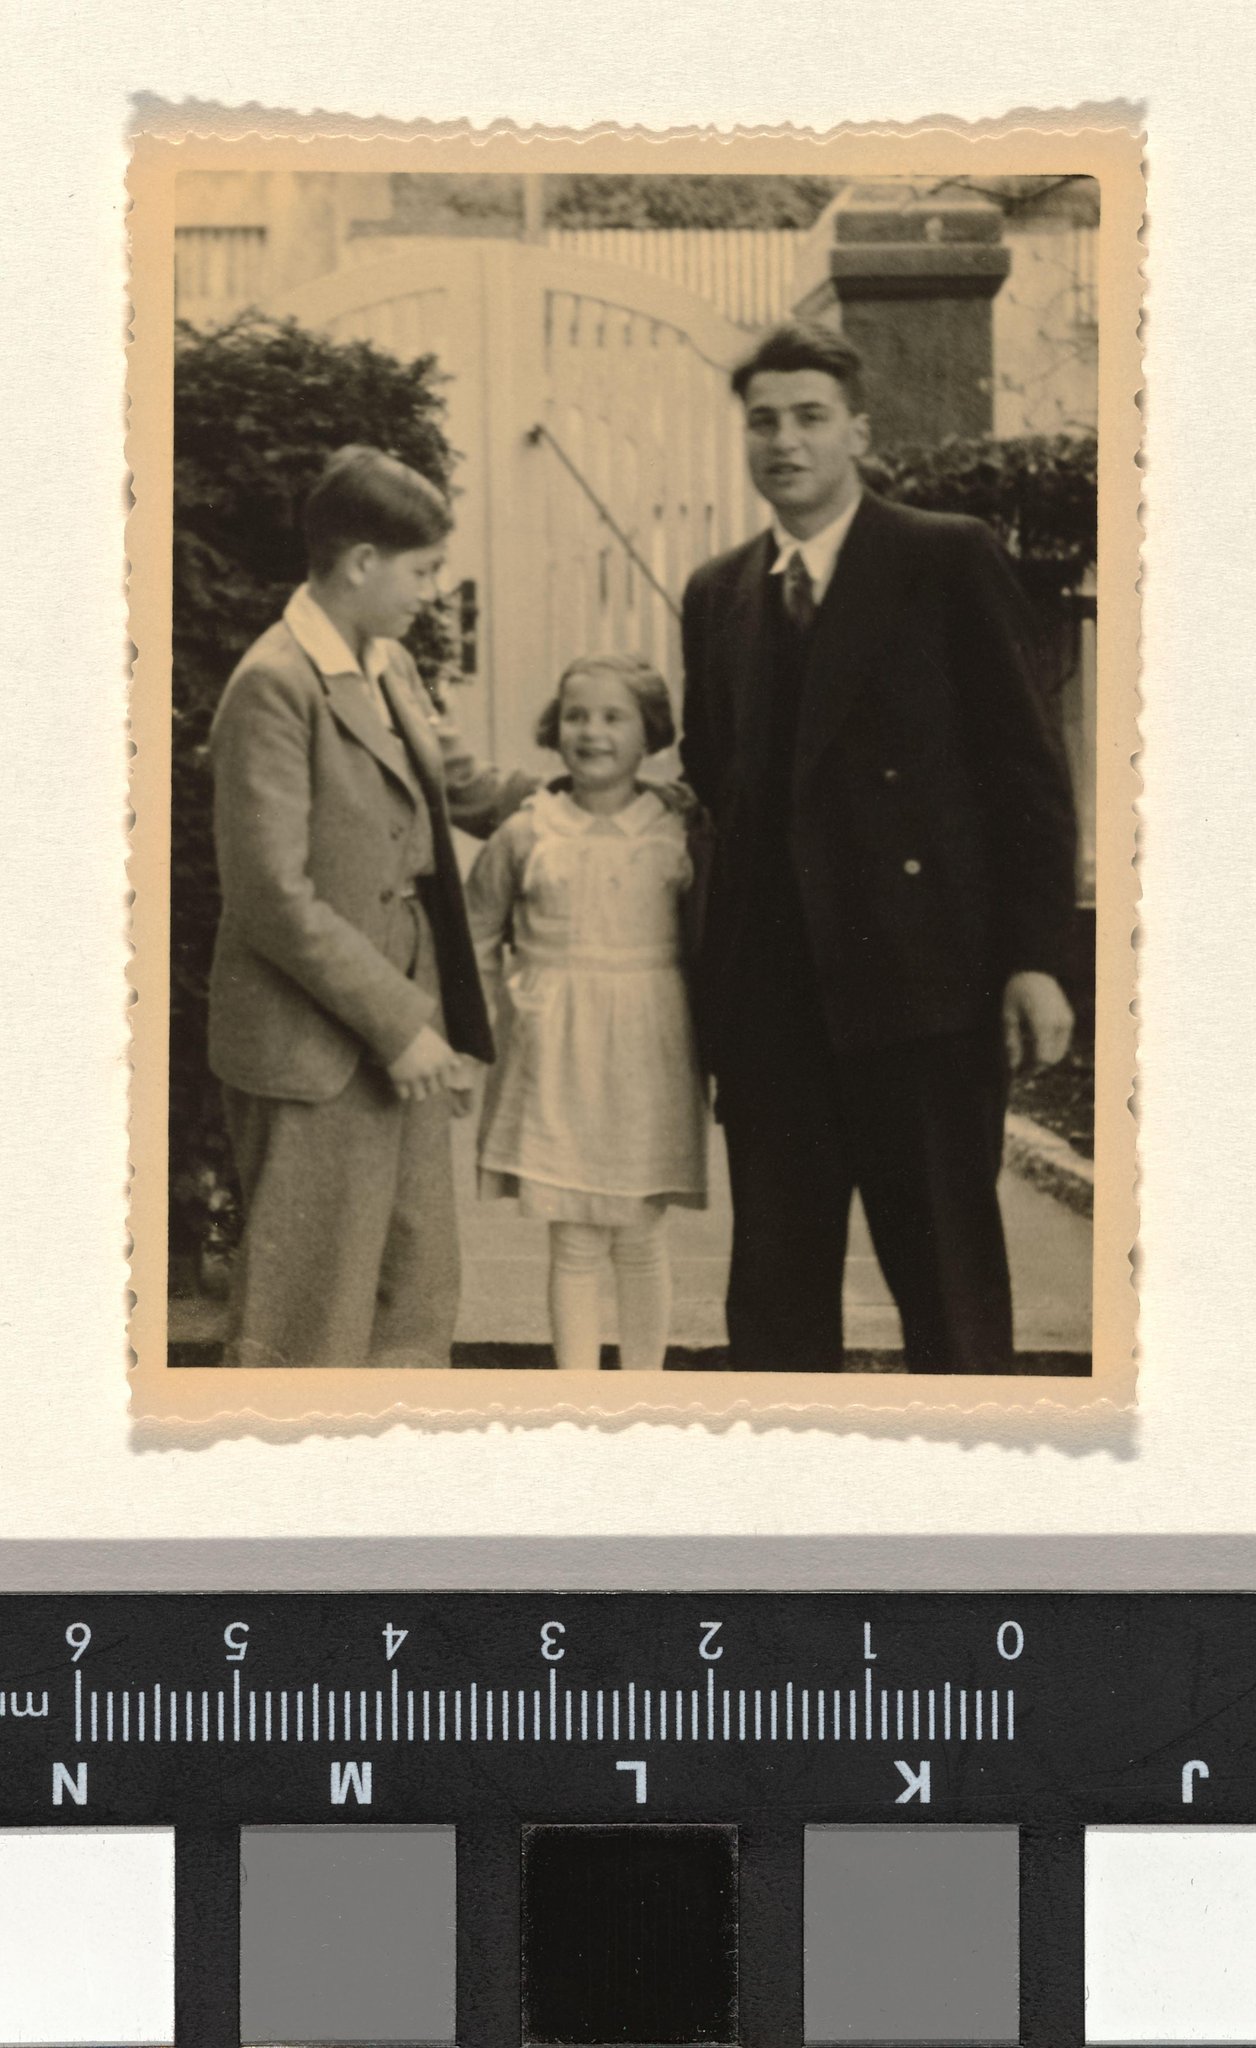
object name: photograph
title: Isabel Wachenheimer met haar neven Klaus en Werner Zürndorfer, in de tuin van de familie Wachenheimer in Stuttgart, 1935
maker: Anonymous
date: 1935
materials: photographic support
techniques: gelatin silver print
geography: stuttgart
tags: leiden, isabel wachenheimer-elon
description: Dit object is onderdeel van de nalatenschap van Isabel Elon-Wachenheimer (1928-2010). Tot haar overlijden behoorde het samen met de andere objecten uit de nalatenschap tot haar privédomein van Isabel Wachenheimer. In die particuliere context zijn deze objecten tezamen en individueel aandenkens - aan de jeugd, ouders en familie van Isabel Wachenheimer vóór en tijdens de Shoah en aan haar leven na de Tweede Wereldoorlog. Isabel Wachenheimer, die van juni 1943 tot mei 1945 gevangen zat in Kamp Westerbork, Theresienstadt, Auschwitz, Lenzing a/d Oberdonau (een buitenkamp van Mauthausen), overleefde de Shoah. Haar ouders – Eugène Wachenheimer en Else Wachenheimer-Moos - werden op 14 oktober 1944 in Auschwitz-Birkenau vermoord.